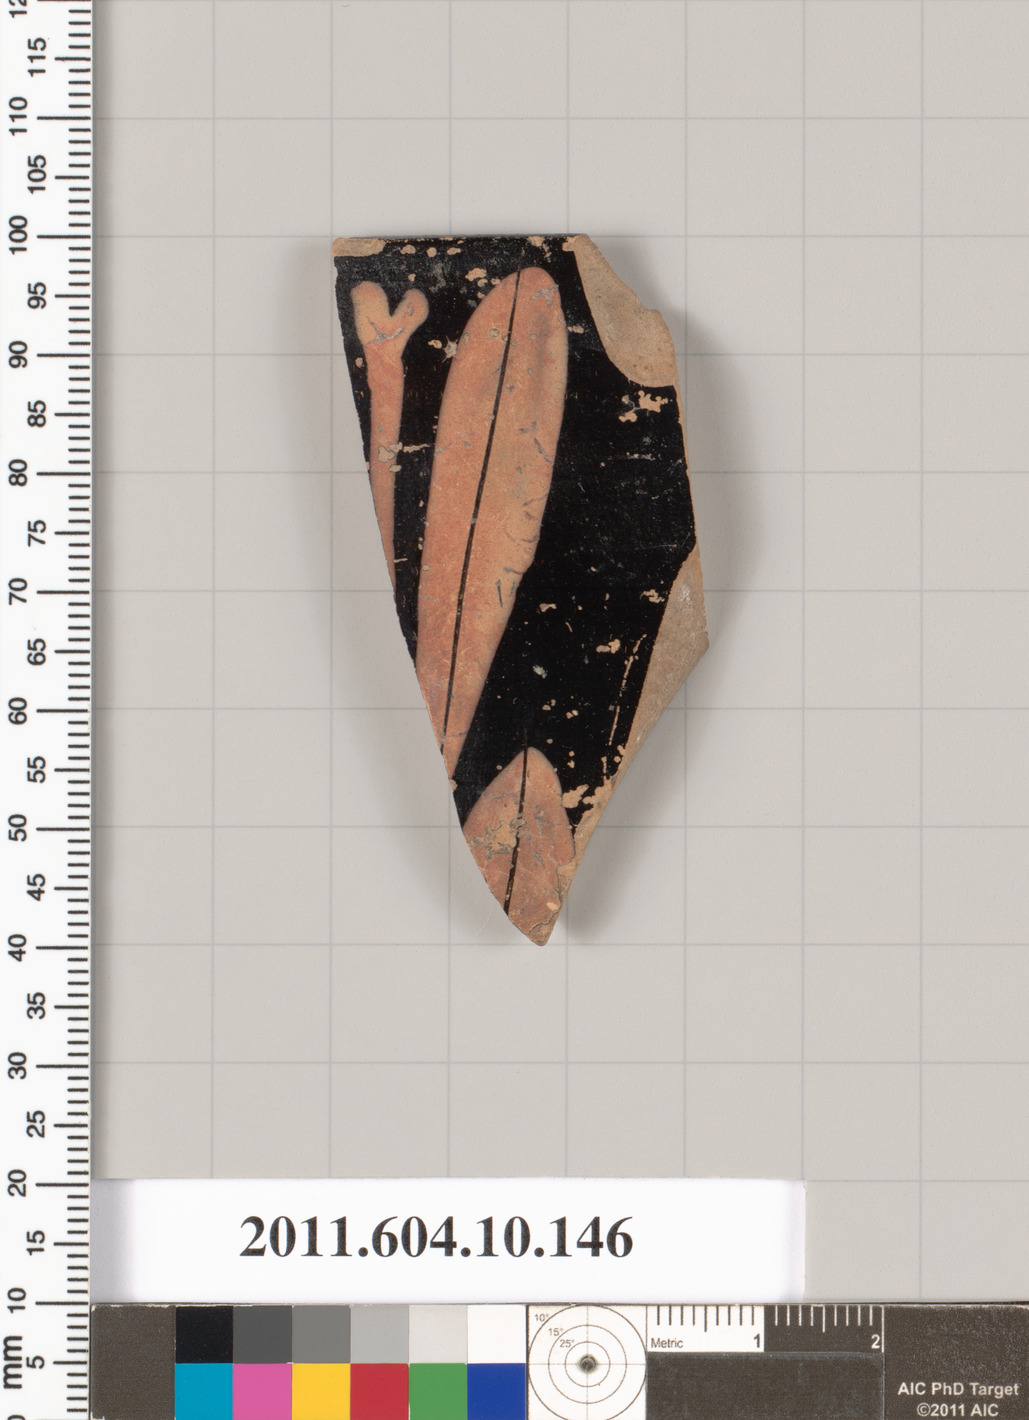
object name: skyphos fragment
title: Terracotta rim fragment of a skyphos (deep drinking cup)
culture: etruscan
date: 434-401 BCE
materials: terracotta